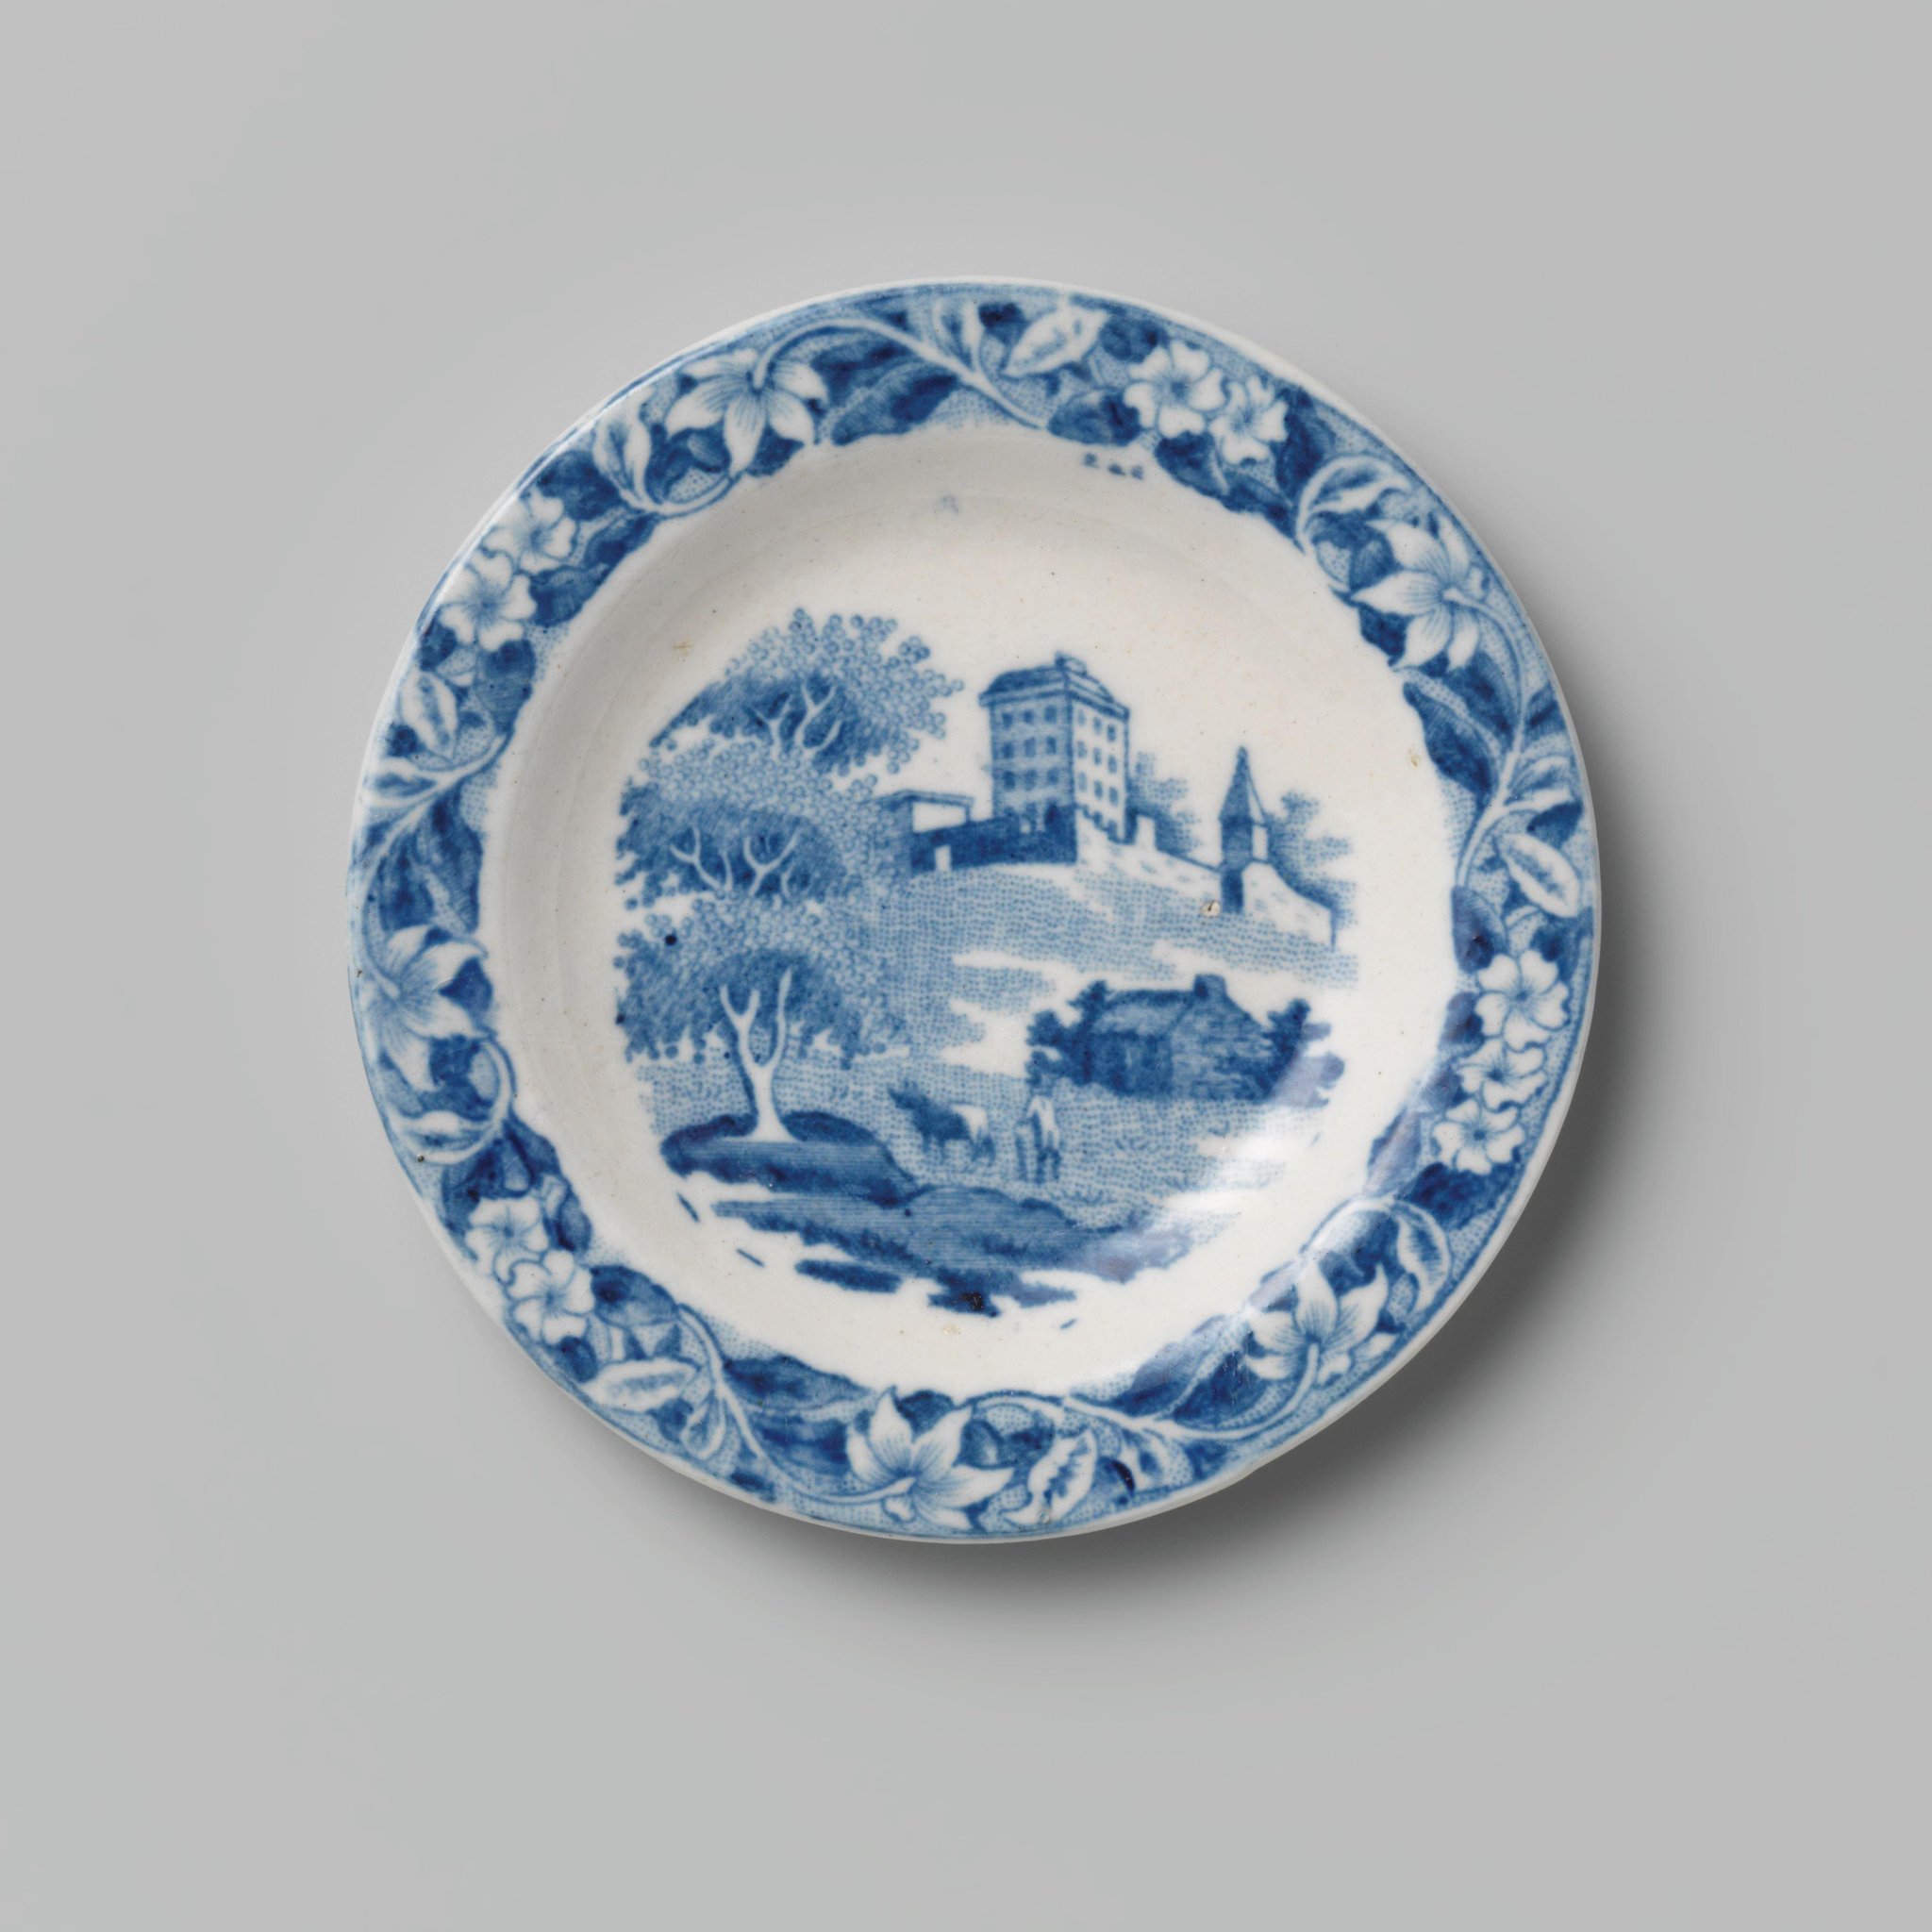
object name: plate dish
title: Rond, plat bord van hardgebakken aardewerk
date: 1840-1860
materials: earthenware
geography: shelton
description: Rond, plat bord van hardgebakken aardewerk met op het plat een decoratie in blauw van een landschap met gebouwen, een boom en een man met een dier. De rand is versierd met bloemtakken. Het bord is gemerkt: Hackwood. Bij het bord horen drie gelijke borden (BK-NM-14091-A t/m BK-NM-14091-D).